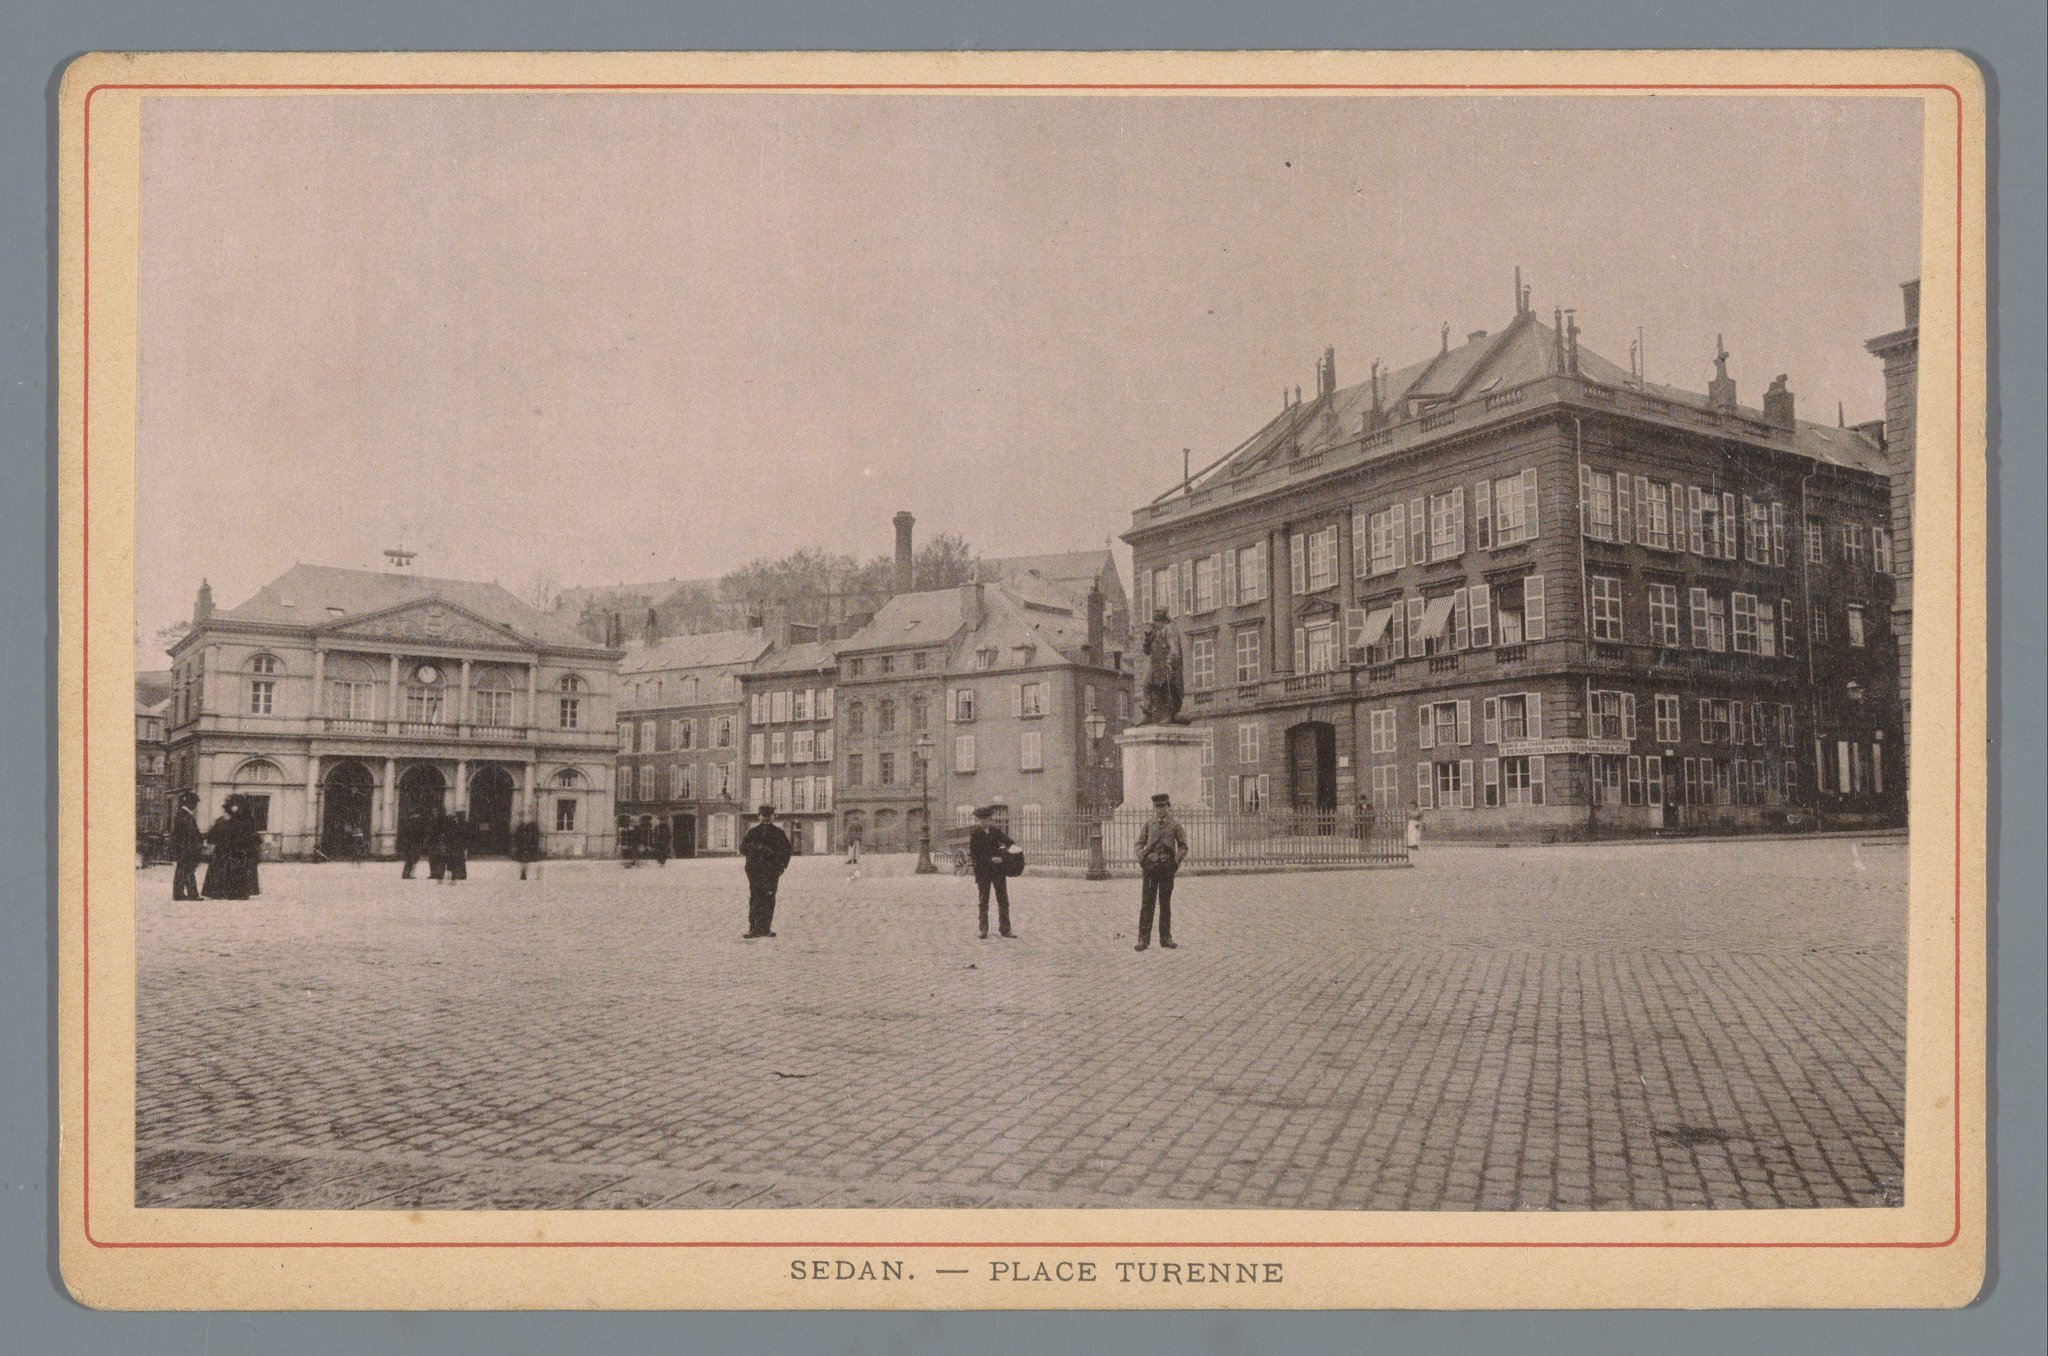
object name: photomechanical print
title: Gezicht op Place Turenne te Sedan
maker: e. genin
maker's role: fotograaf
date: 1880-1910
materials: cardboard, paper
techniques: photograph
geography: sedan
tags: square, place, circus, etc., anonymous historical persons portrayed in a group, in a group-portrait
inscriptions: inscription: ‘La place Turenne est l'une des pricipales de la ville de Sedan (...)’